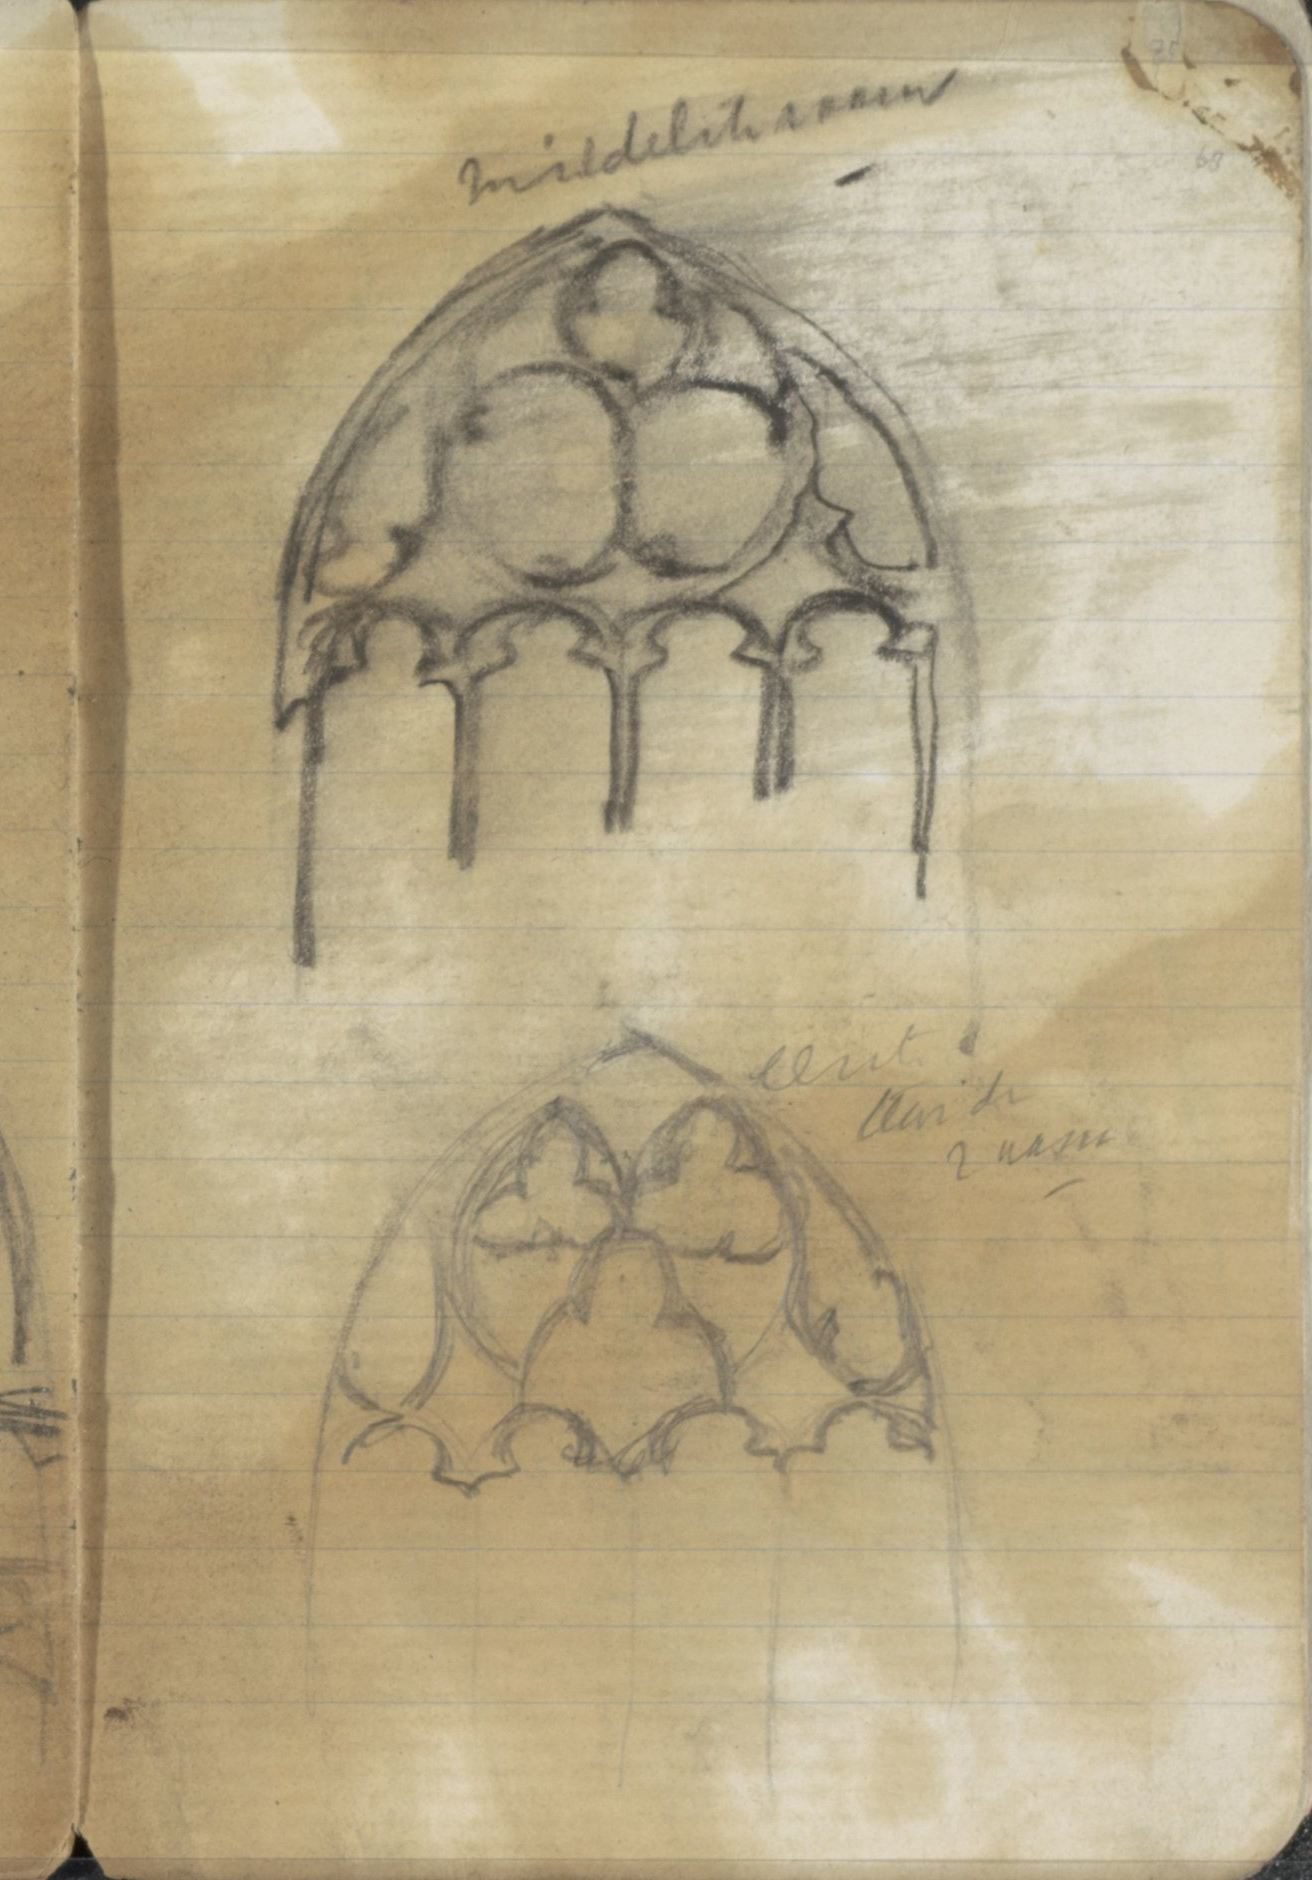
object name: sketchbook leaf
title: Maaswerk van de Nieuwe Kerk te Amsterdam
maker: george hendrik breitner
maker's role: draughtsman, painter, print maker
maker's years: 1857-1923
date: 1896-1901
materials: chalk, pencil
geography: amsterdam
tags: ornament ~ tracery, church-window, e.g. rose-window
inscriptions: annotation: ‘[...]’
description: Ronde pas en drieblad. Pagina 68 uit een schetsboek met 37 bladen.